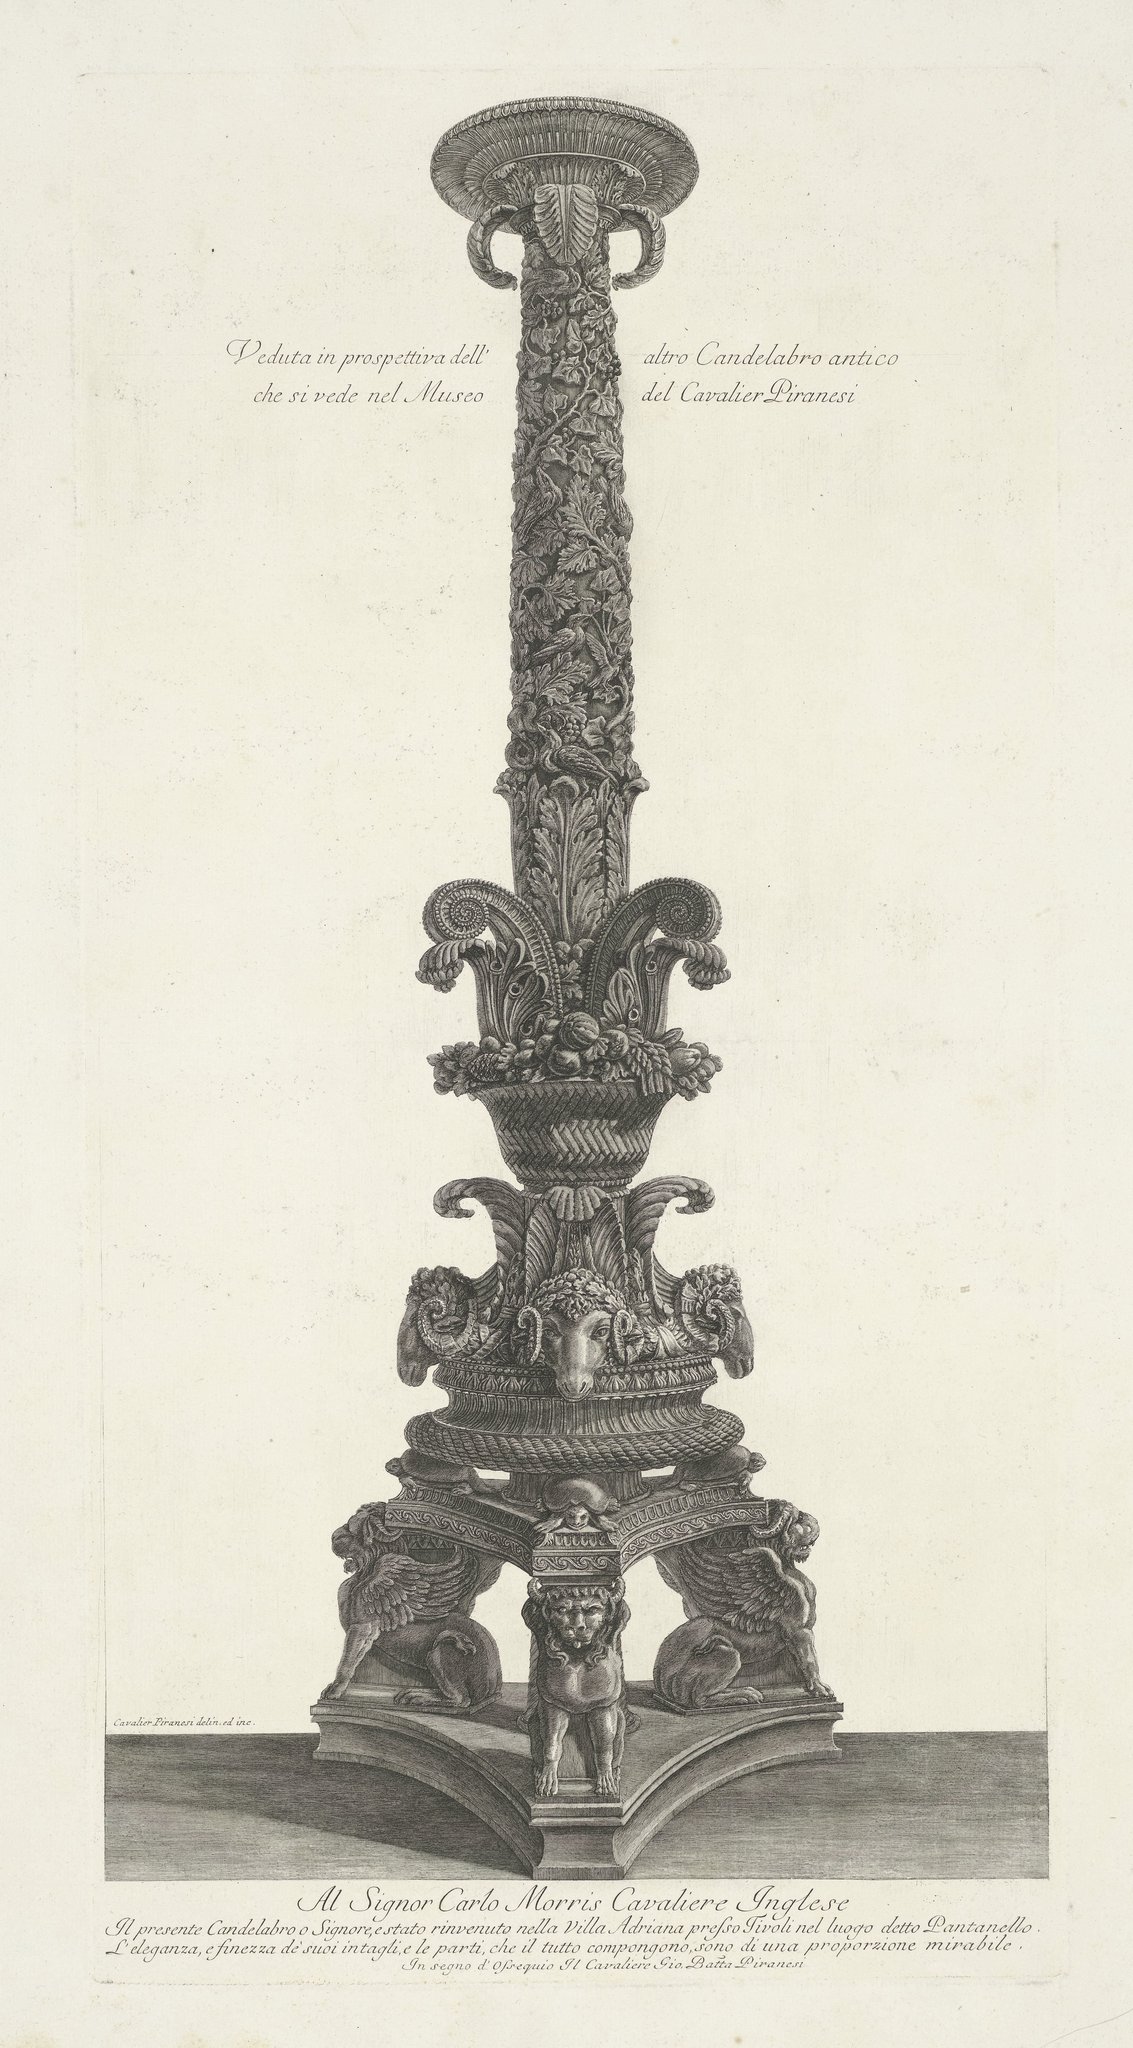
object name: print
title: Vasi, candelabri, cippi, sarcofagi, tripodi, lucerne, ed ornamenti antichi disegn. ed incisi dal cav. Gio. Batta Piranesi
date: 1778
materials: paper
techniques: etching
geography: rome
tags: chandelier, candelabrum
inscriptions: collector's mark: Lugt 2228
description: De 'Vasi'-reeks telt 110 prenten, verspreid over twee volumes met elk een eigen titelprent. Piranesi werd voor deze reeks geholpen door verschillende assistenten uit zijn werkplaats, waaronder zijn zoon Francesco die ook nog eens 8 platen toevoegde aan de reeks in 1779-1780.